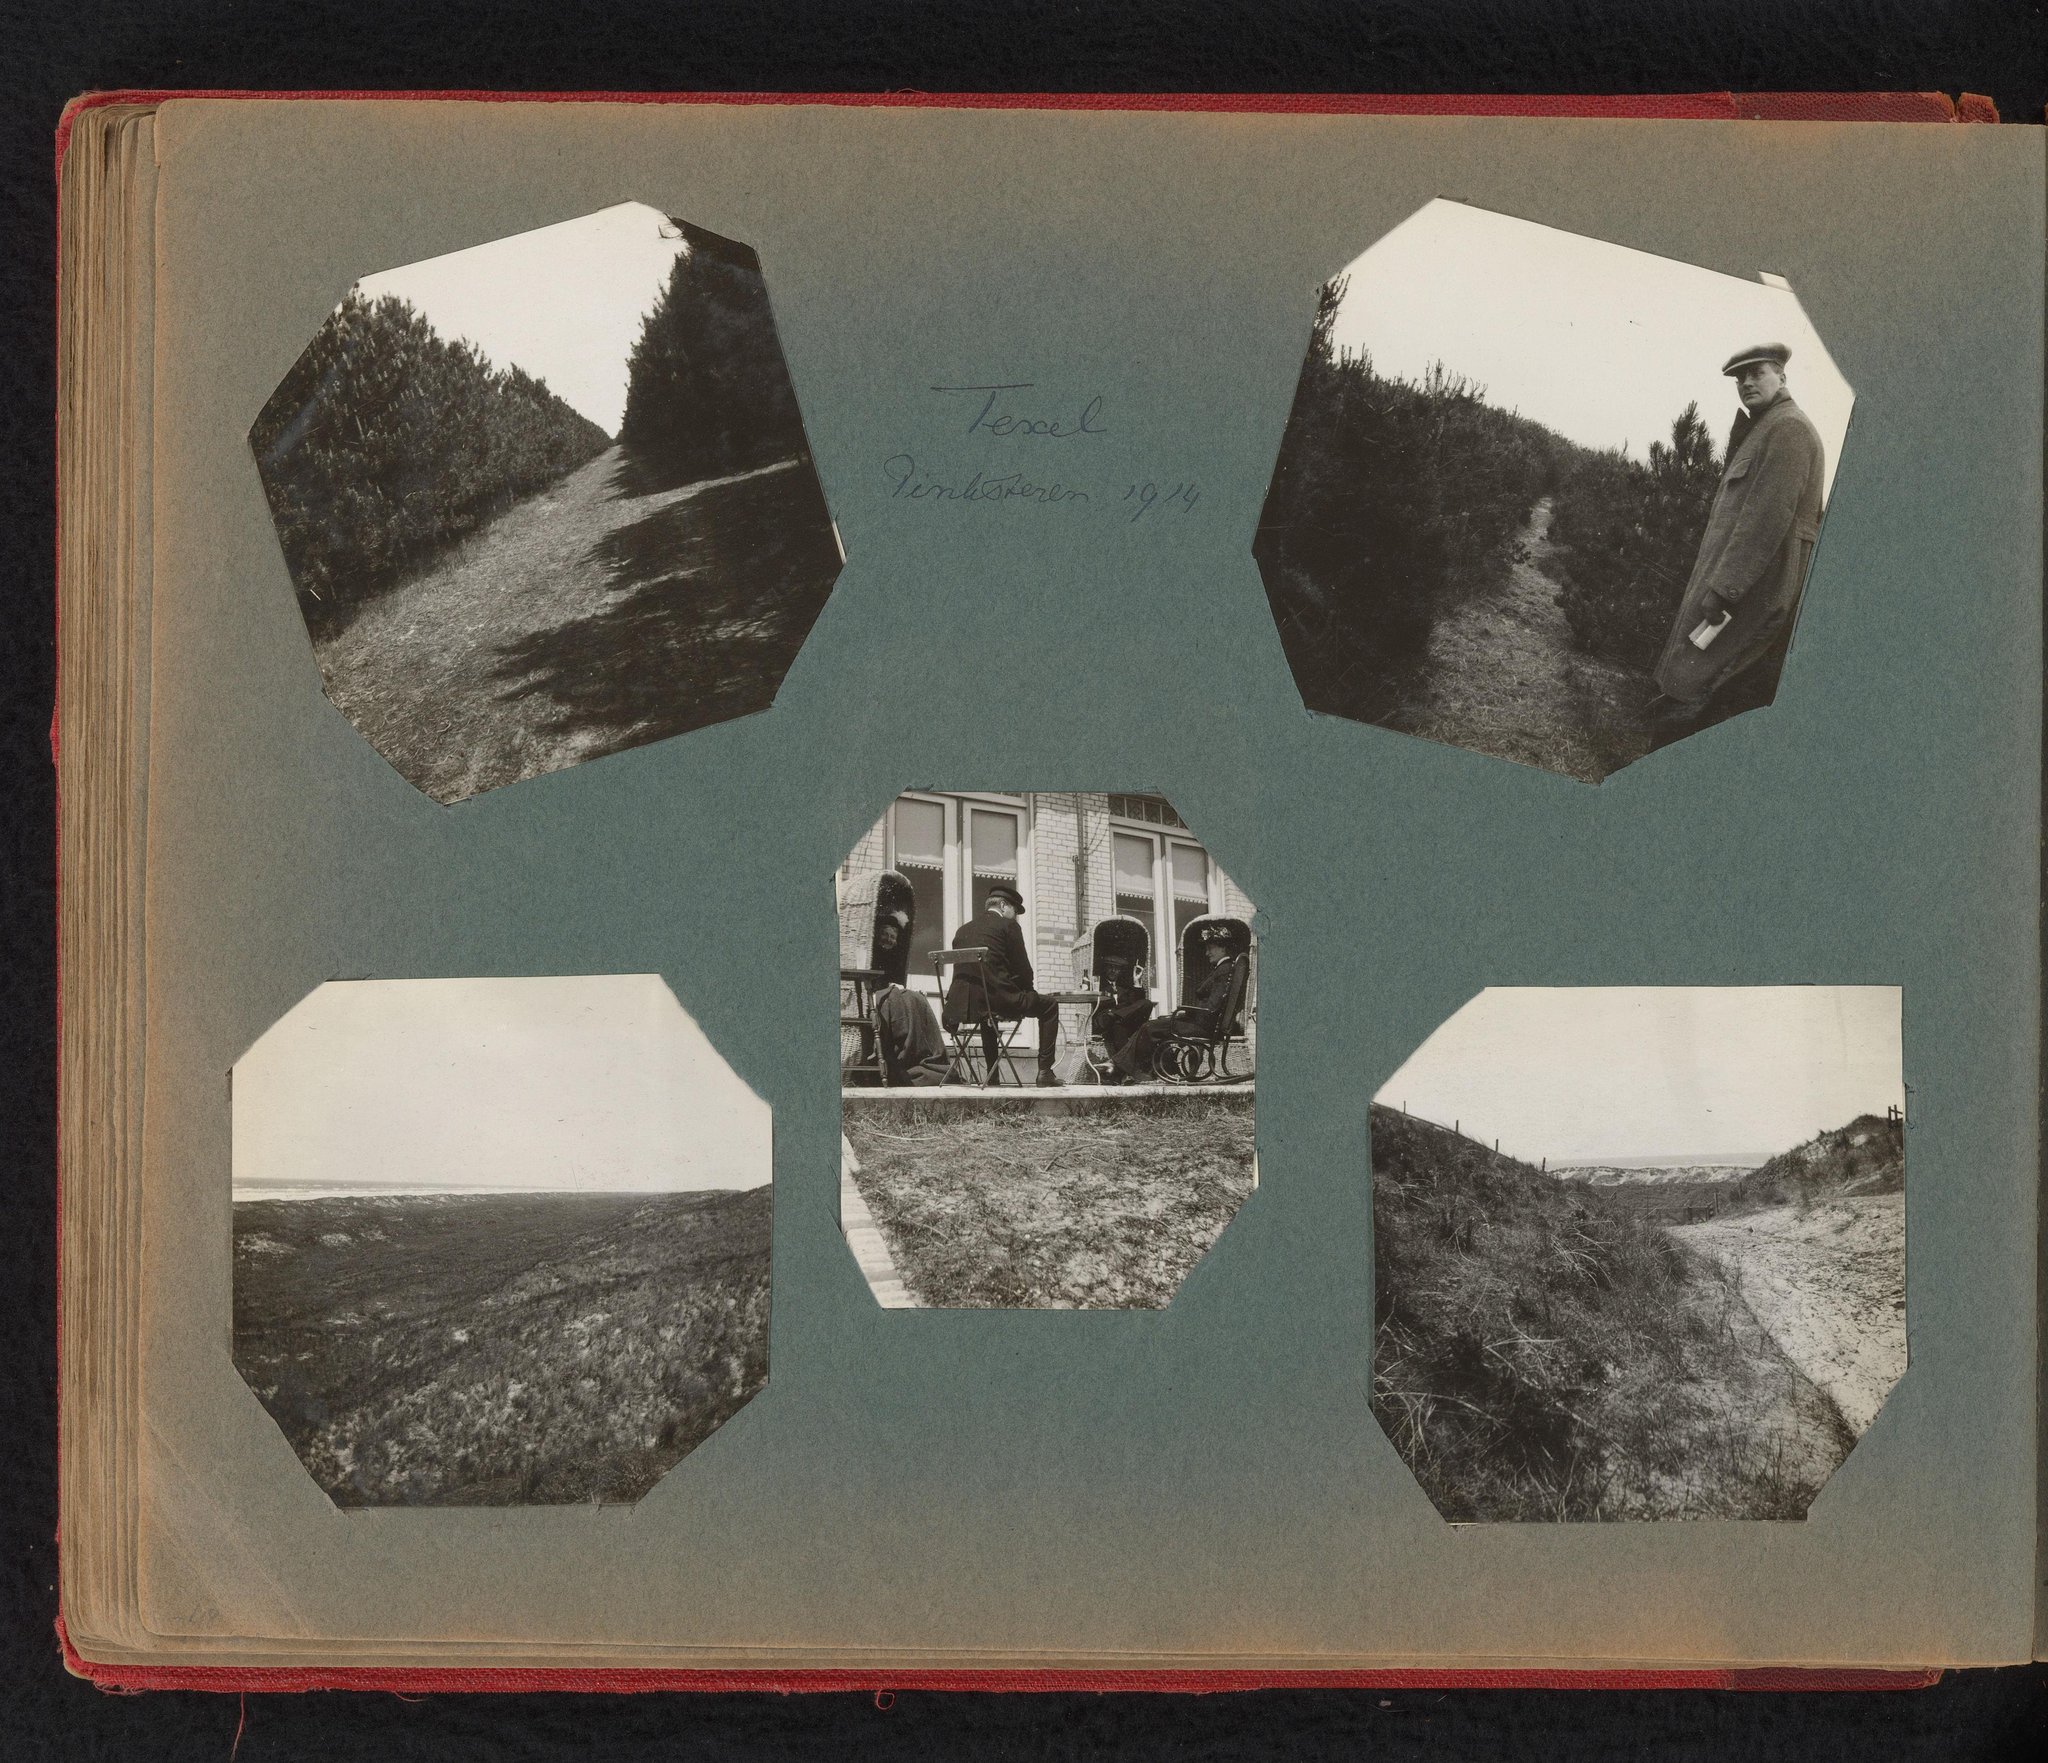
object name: photograph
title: Joan en Charlotte Boelen op Texel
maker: charlotte alida boelen-matthes (lot)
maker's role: amateurfotograaf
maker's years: 1889-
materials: paper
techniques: gelatin silver print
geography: texel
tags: charlotte alida boelen-matthes (lot), joan gerard boelen, recreation in the dunes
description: Deze foto's zijn onderdeel van een album.